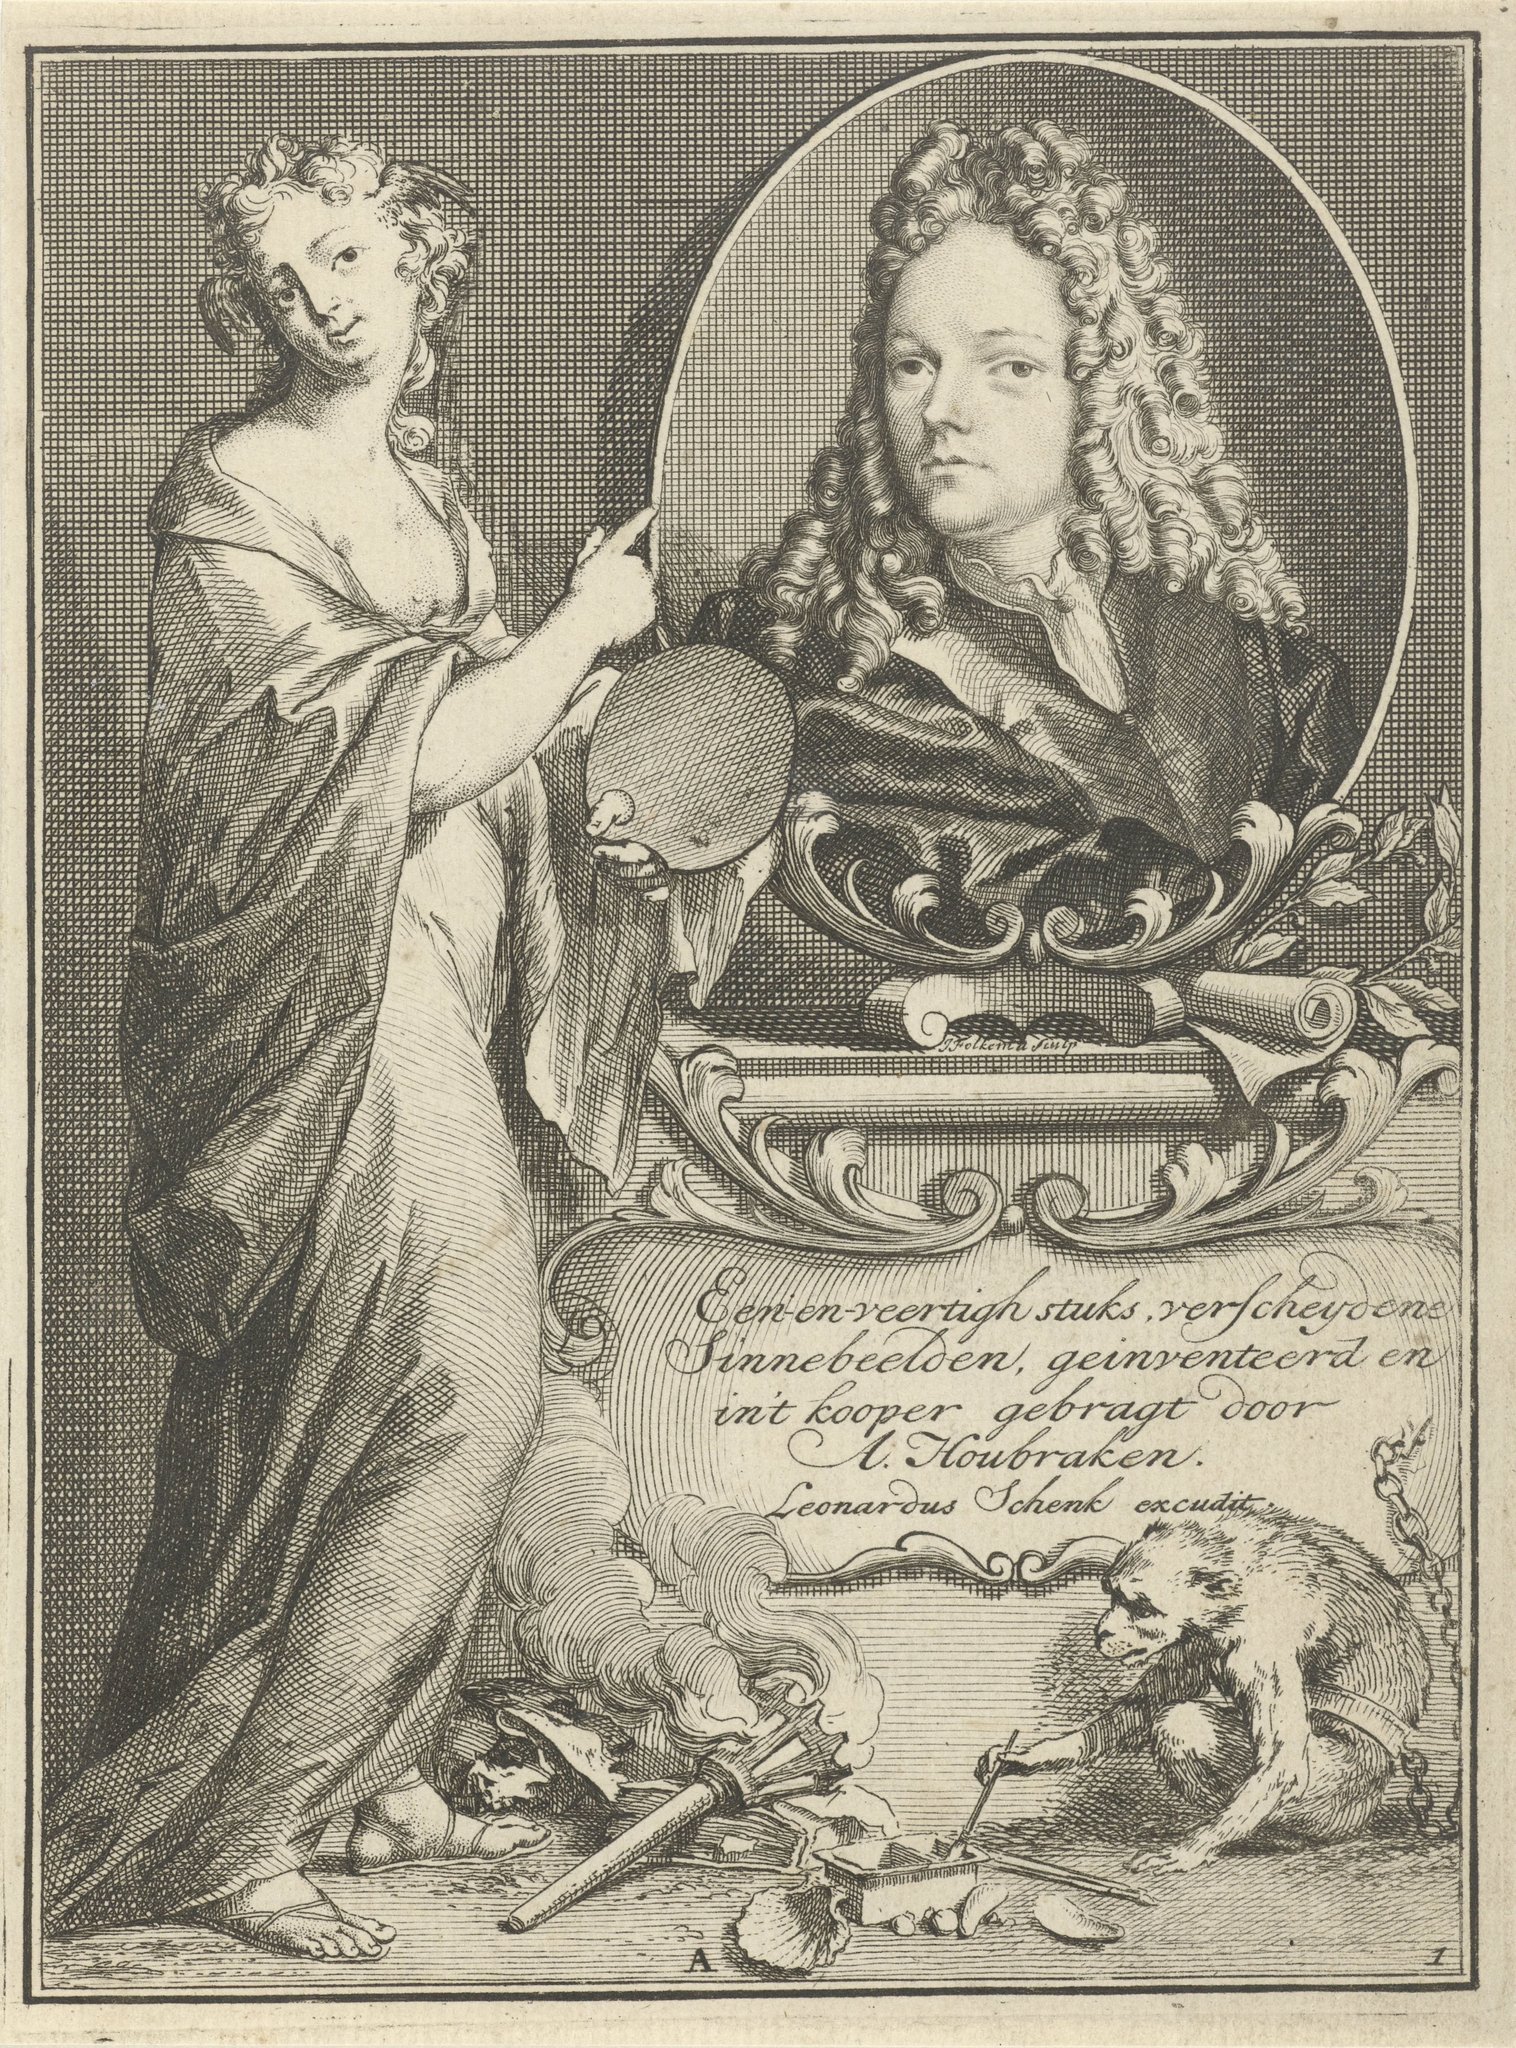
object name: titelprent, frontispice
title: Een-en-veertigh stuks, verscheydene Sinnebeelden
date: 1710-1719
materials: paper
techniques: engraving, etching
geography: amsterdam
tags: dordrecht, amsterdam, painter, draughtsman, arnold houbraken, torch, monkeys, apes (+ animals used symbolically), portrait, self-portrait of artist, palette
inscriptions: collector's mark: Lugt 2228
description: Een vrouwfiguur met een schilderspalet in haar linkerhand wijst op het portret van Arnold Houbraken in een ovaal. Onder het portret een cartouche met daarop de serietitel. Daaronder een vastgeketende aap met een penseel in zijn hand en op de grond onder andere een brandende fakkel. Titelprent van een serie van 41 zinnebeelden.